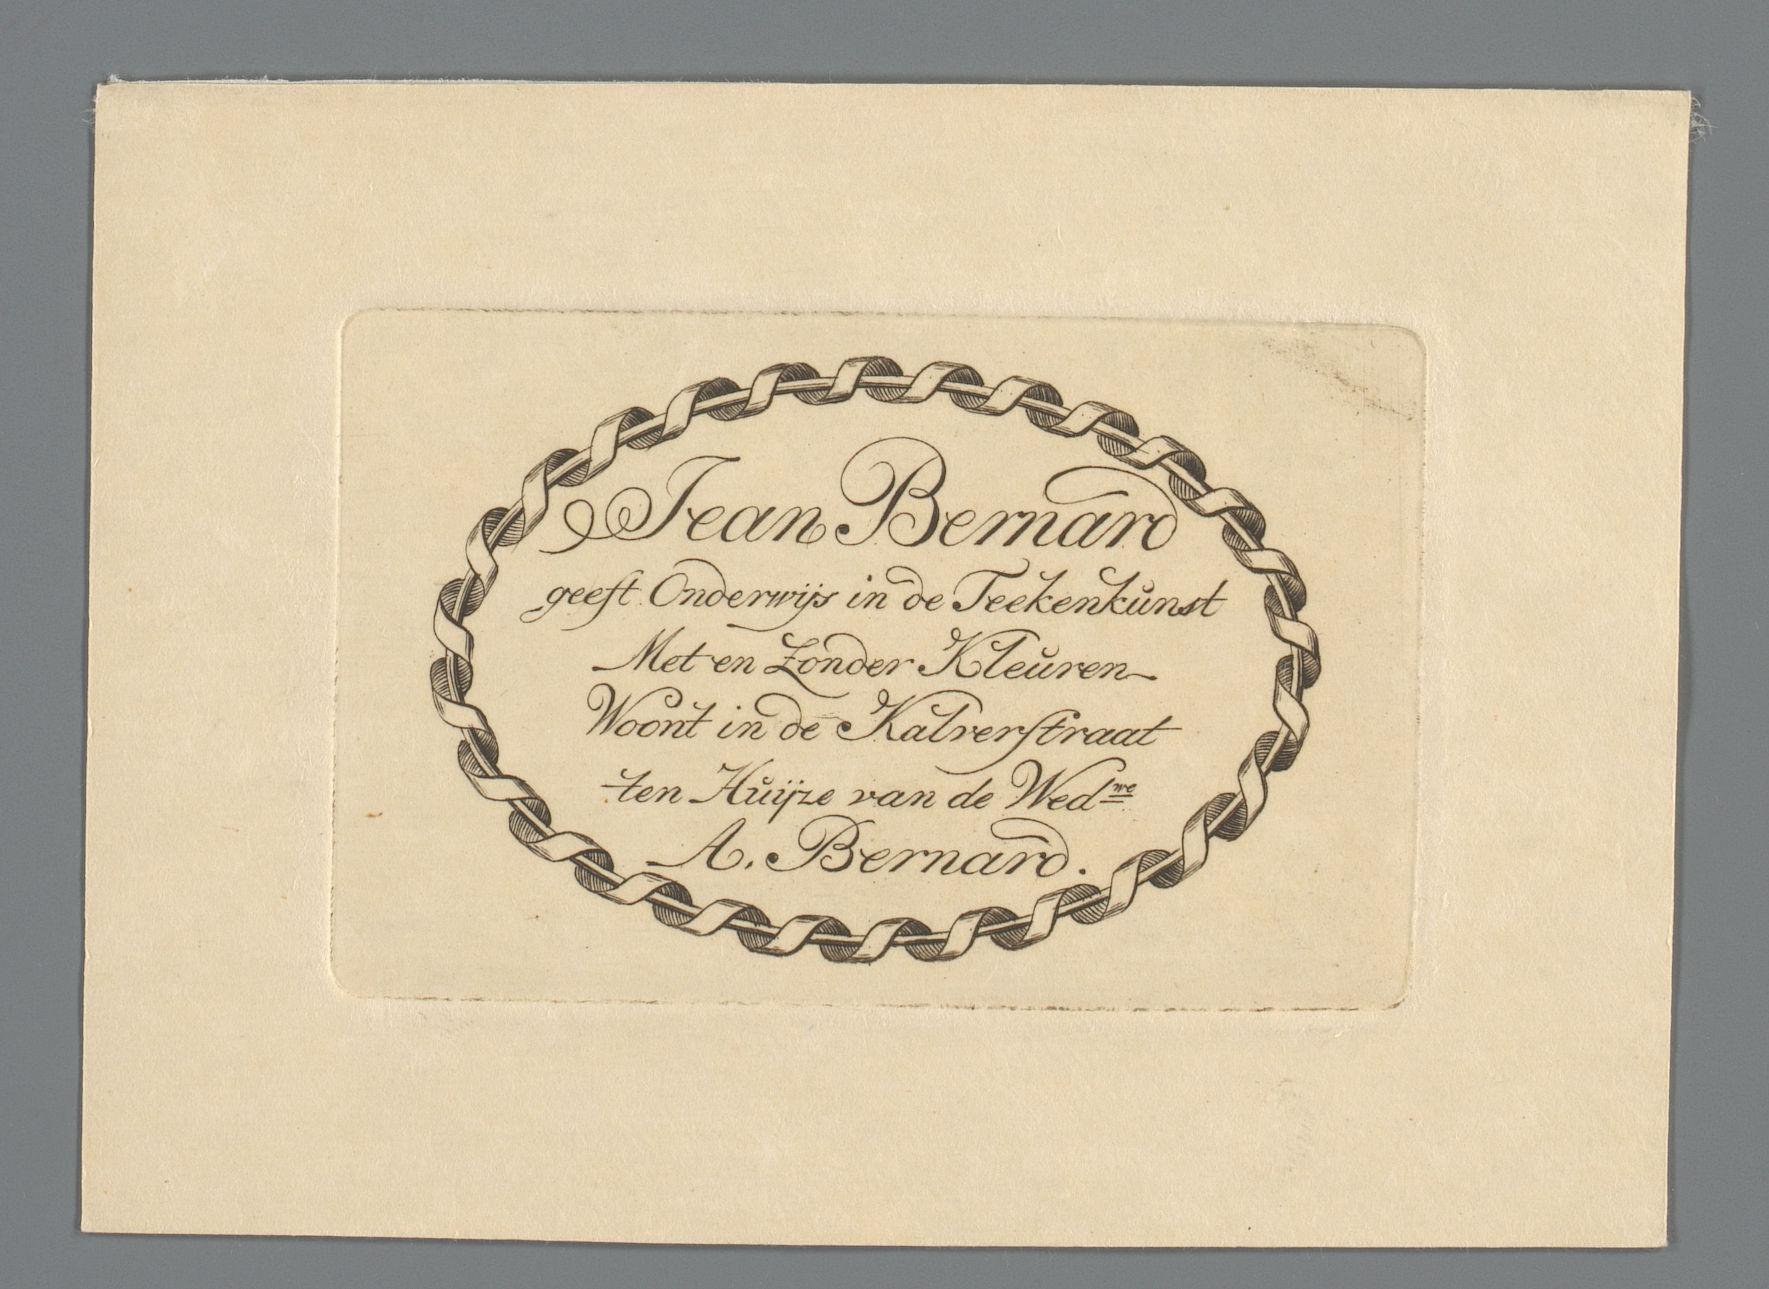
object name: business card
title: Adreskaart van Jean Bernard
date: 1775-1833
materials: paper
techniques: engraving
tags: print maker, draughtsman, jean bernard, visiting-card, calling-card, amsterdam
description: In een ovale omlijsting: 'Jean Bernard geeft Onderwijs in de Teekenkunst Met en Zonder Kleuren. Woont in de Kalverstraat ten Huijze van den Wedwe. A. Bernard'.